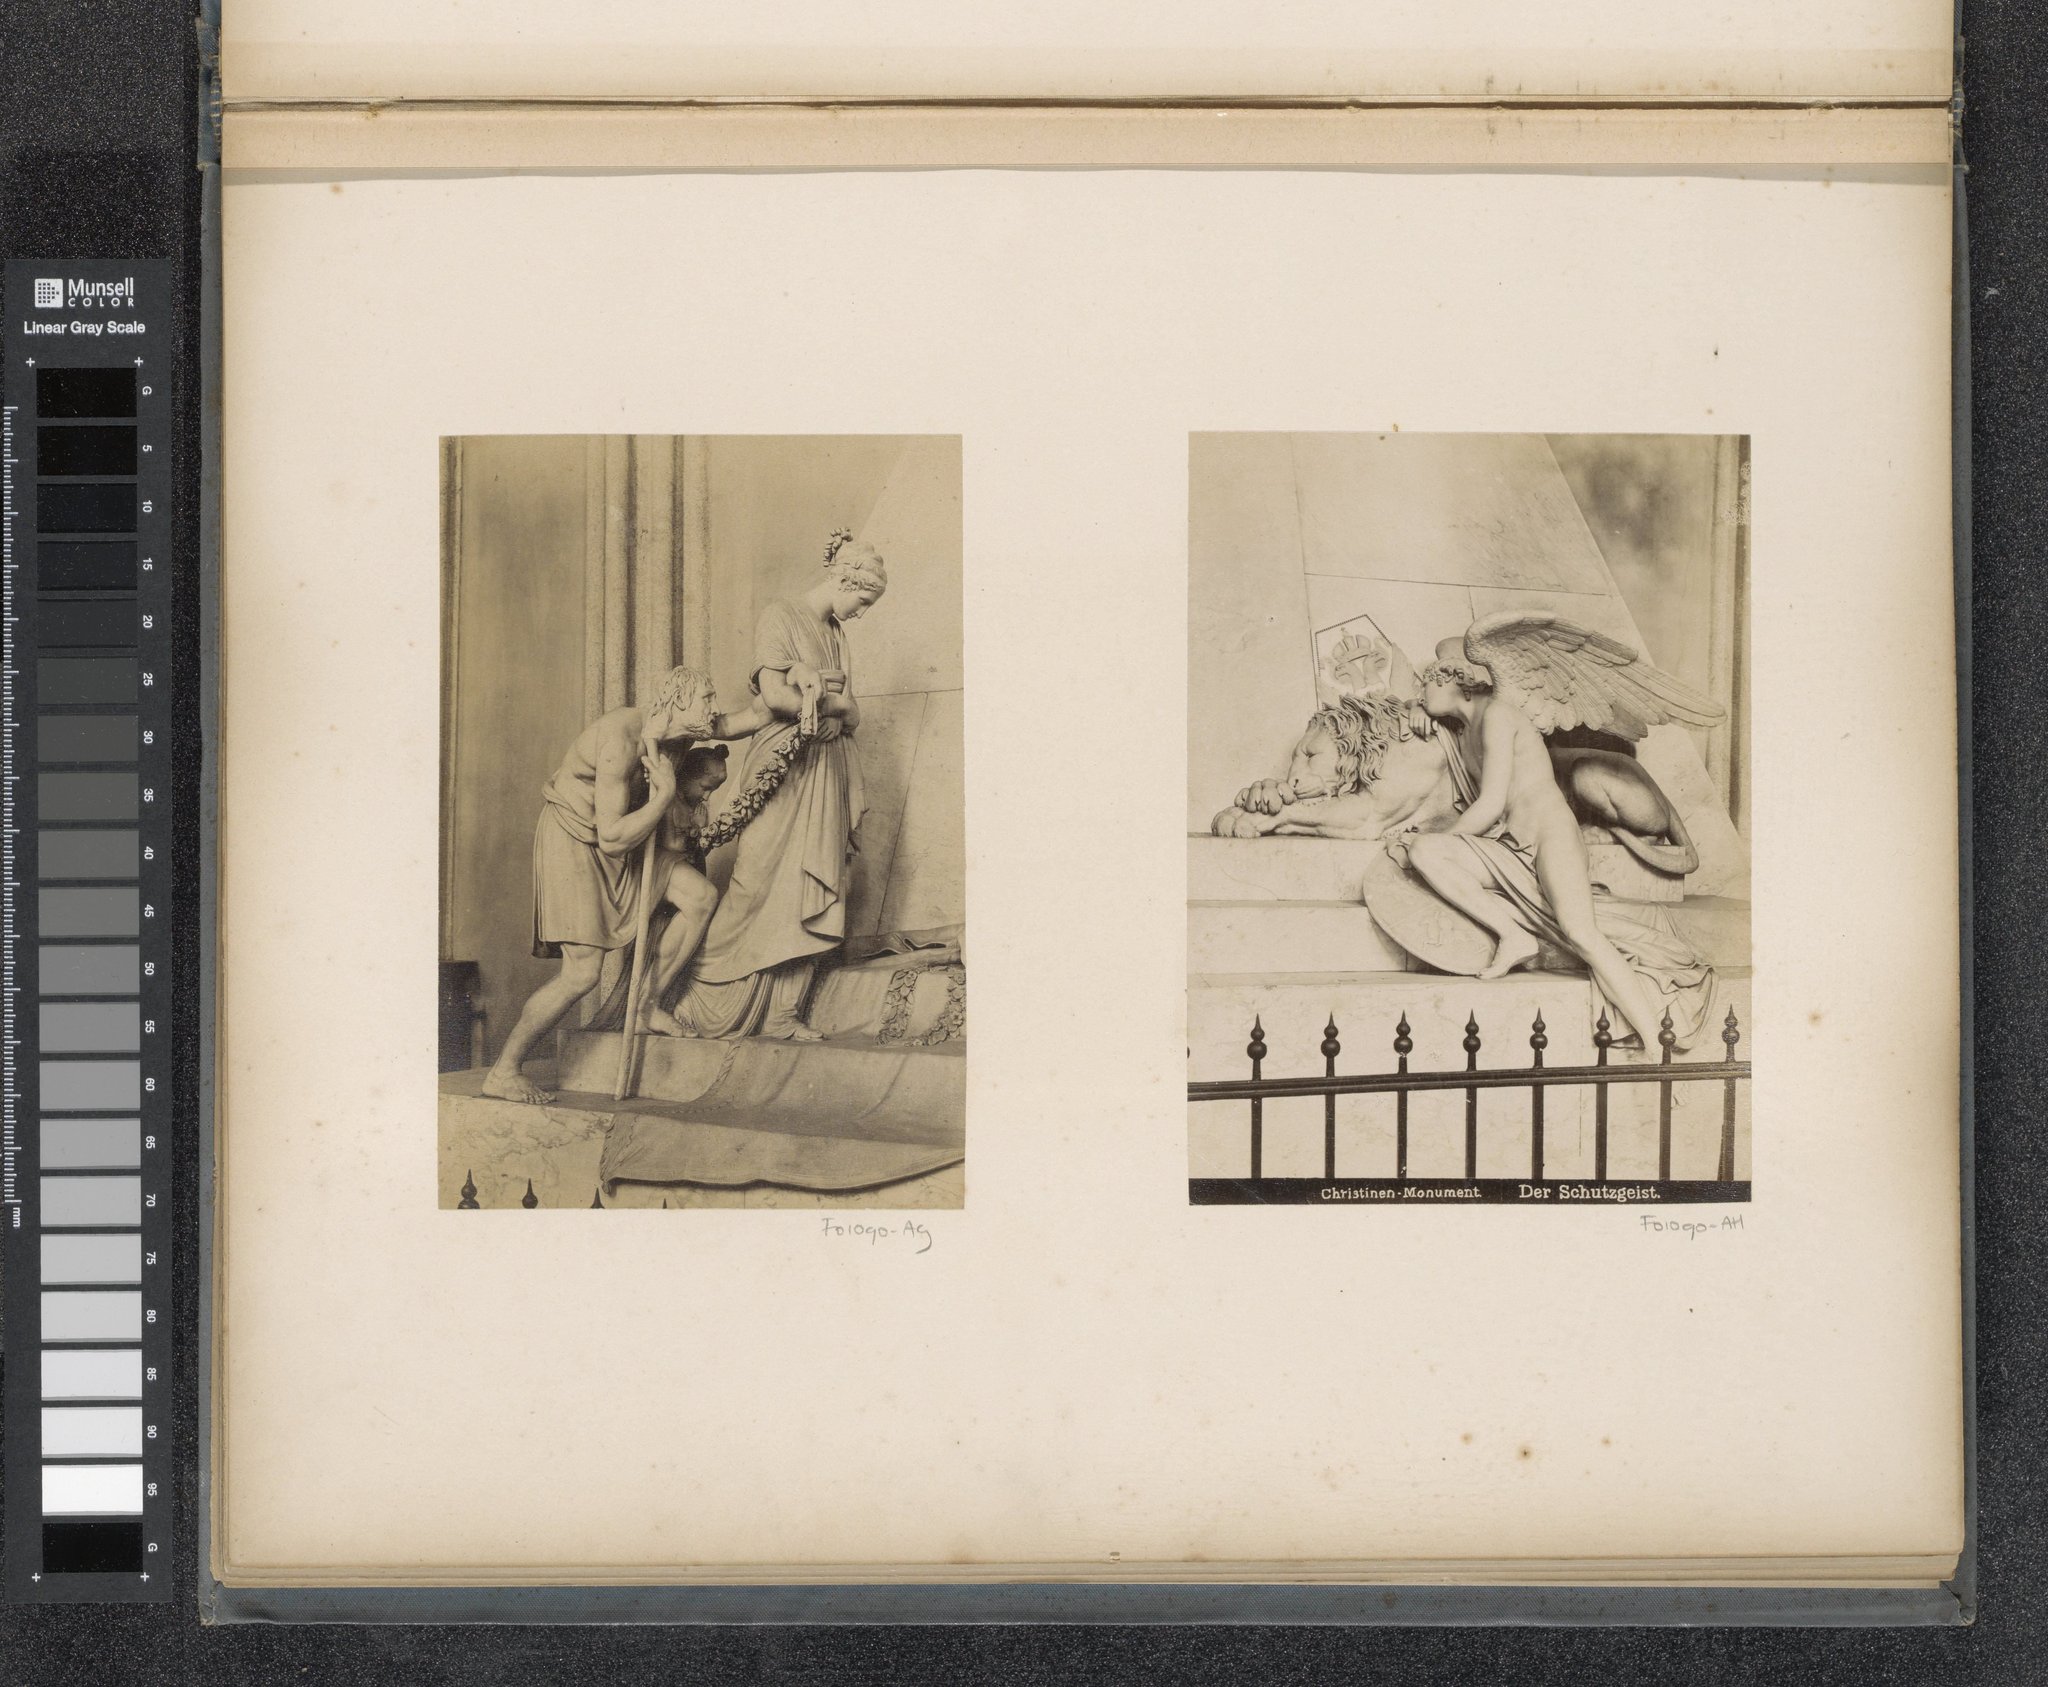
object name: photograph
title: Christinen-Monument. Der Schutzgeist.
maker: Anonymous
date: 1870-1900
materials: paper, photographic support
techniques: albumen print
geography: vienna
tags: sham-grave, cenotaph, piece of sculpture, reproduction of a piece of sculpture, vienna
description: Onderdeel van Reisalbum met foto's van bezienswaardigheden in Duitsland en Oostenrijk en van kunstwerken.